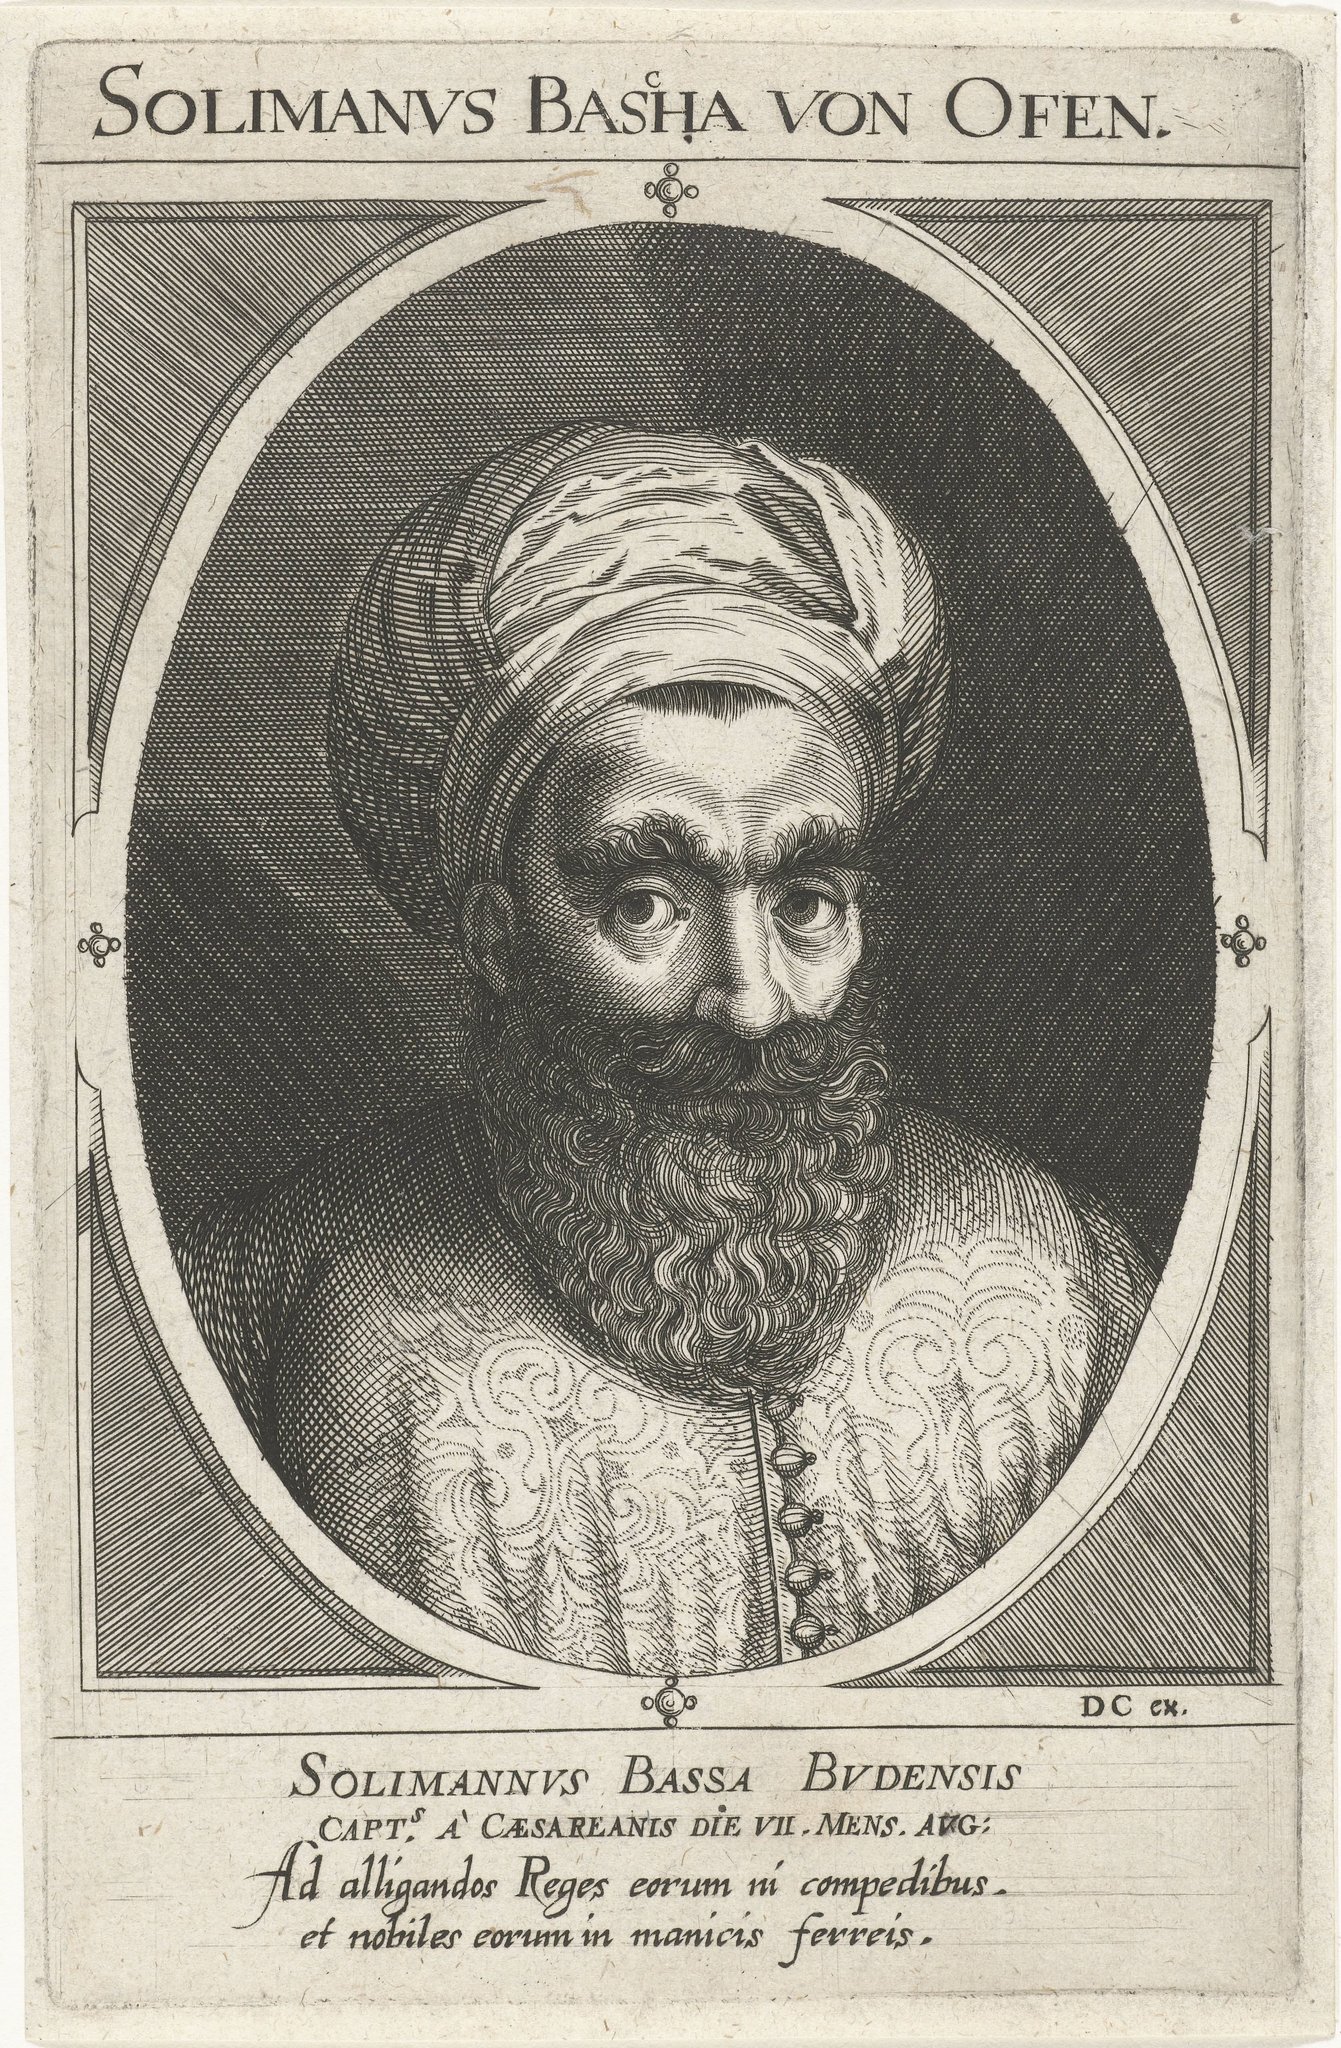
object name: print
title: Atrium Heroicum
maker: dominicus custos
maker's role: print maker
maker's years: 1560-1615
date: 1600-1604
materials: paper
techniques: engraving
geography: augsburg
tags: sari süleyman (pasja van turkije)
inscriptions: collector's mark: Lugt 2228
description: Illustratie uit: D. Custos en M. Henning. Atrium heroicum Caesarum, regum aliorq. summatum ac procerum qui intra proximum seculum vixere, aut hodie supersunt, imaginib. Deel 1-4. Augsburg: D. Custos, 1600-1604.